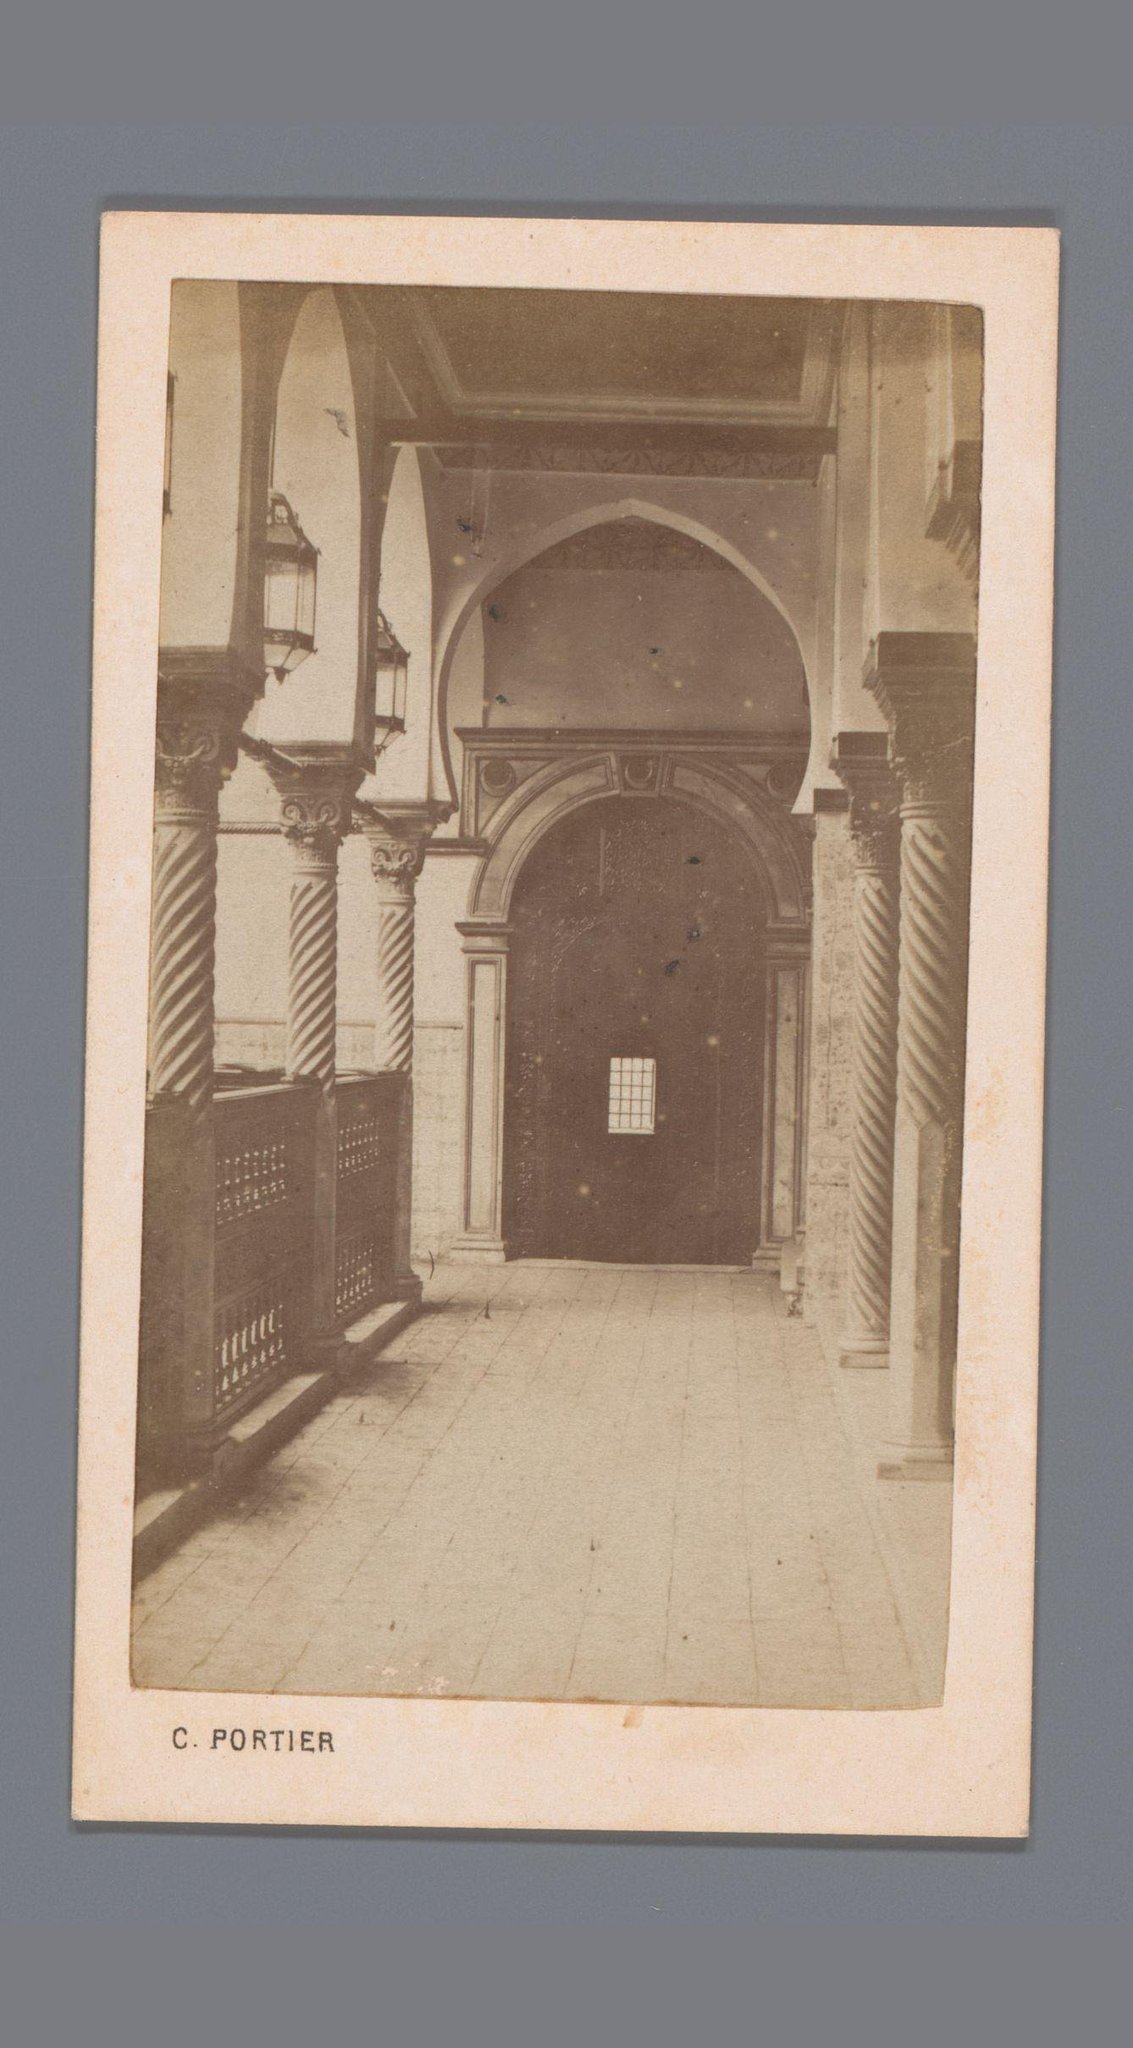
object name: photograph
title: Galerij in Algiers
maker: claude-joseph portier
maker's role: fotograaf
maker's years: 1841-1910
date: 1863-1882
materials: cardboard, paper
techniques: albumen print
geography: algiers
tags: arcade ~ architecture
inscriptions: inscription: ‘C. Portier/ Photographe Paysagiste/ Alger/ Vues et types de toute l'Algérie/ Magasin de vente/ Rue bab-Azoun,/ (au coin de la Rue de la Flèche)’, inscription: ‘C. Portier’